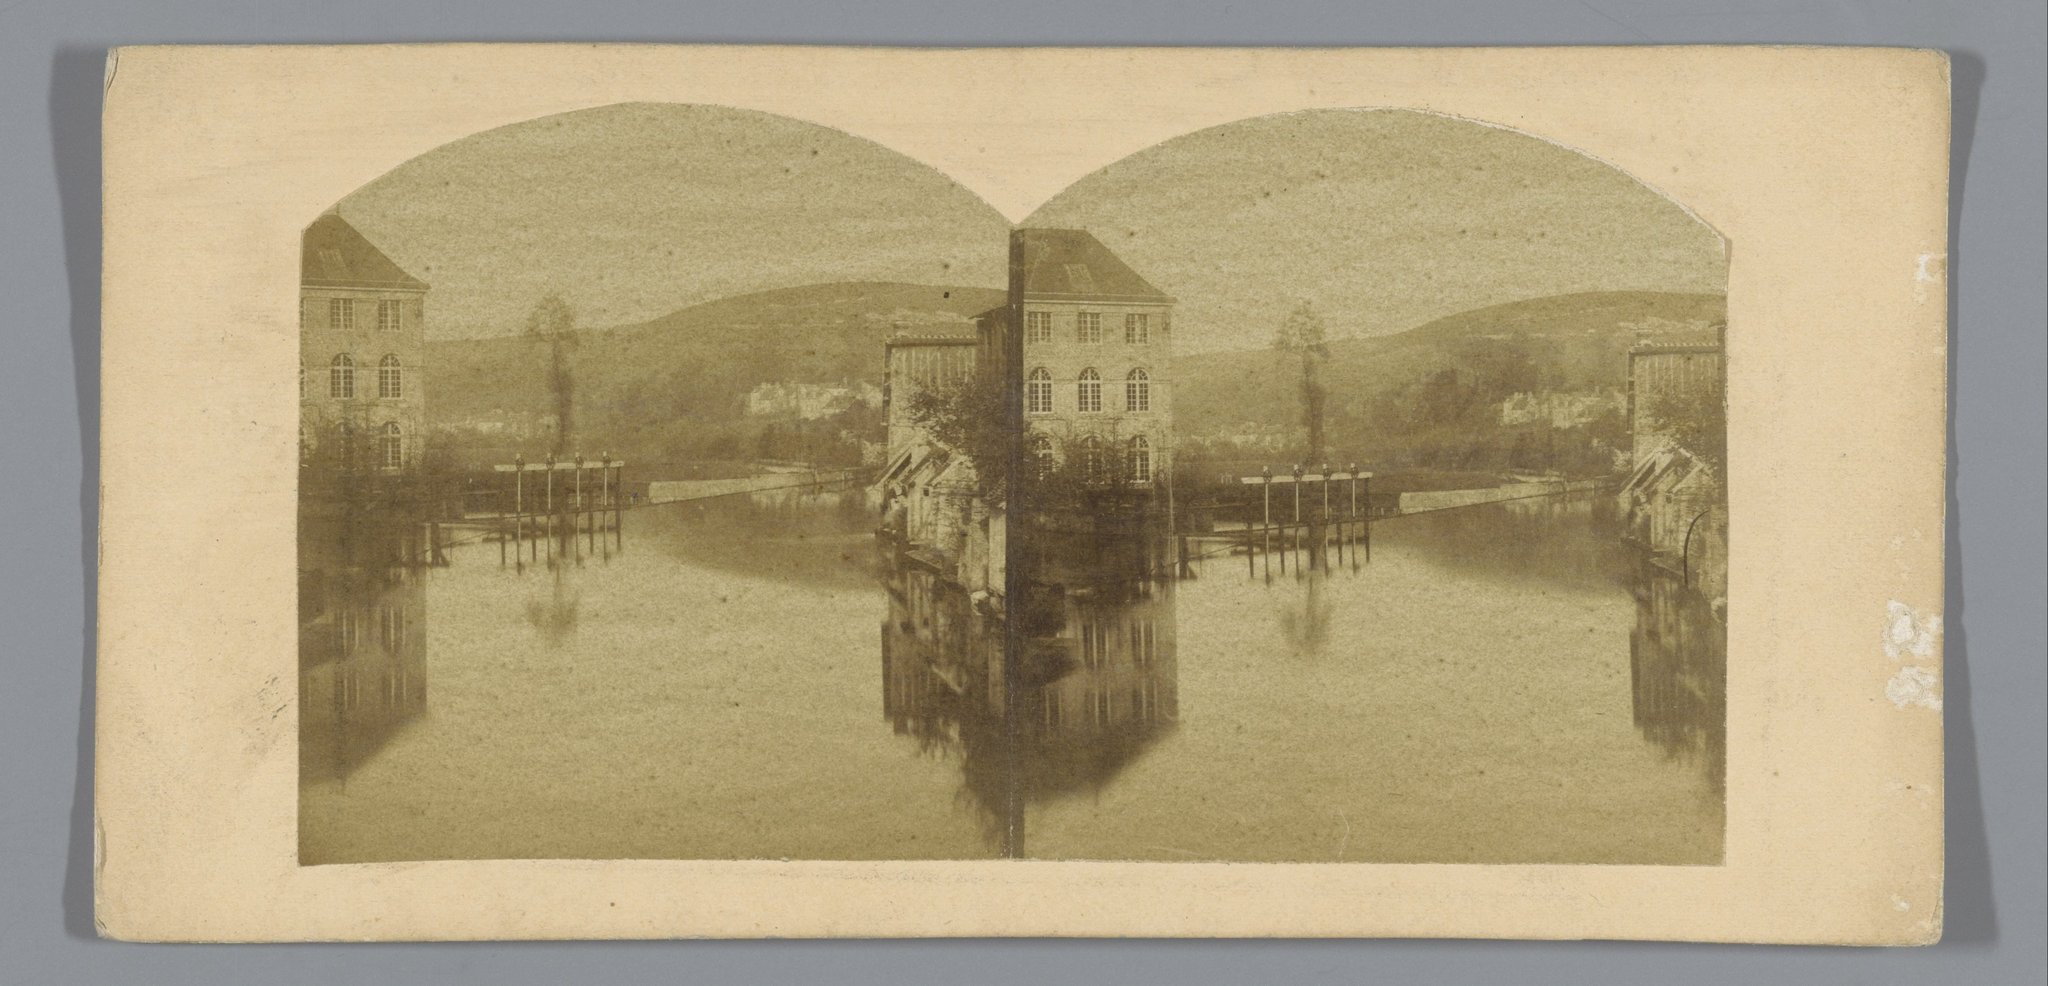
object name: stereograph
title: Huizen langs een rivier of meer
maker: Anonymous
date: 1852-1863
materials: cardboard, paper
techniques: albumen print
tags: river, housing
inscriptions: number: ‘No 30/ 25’